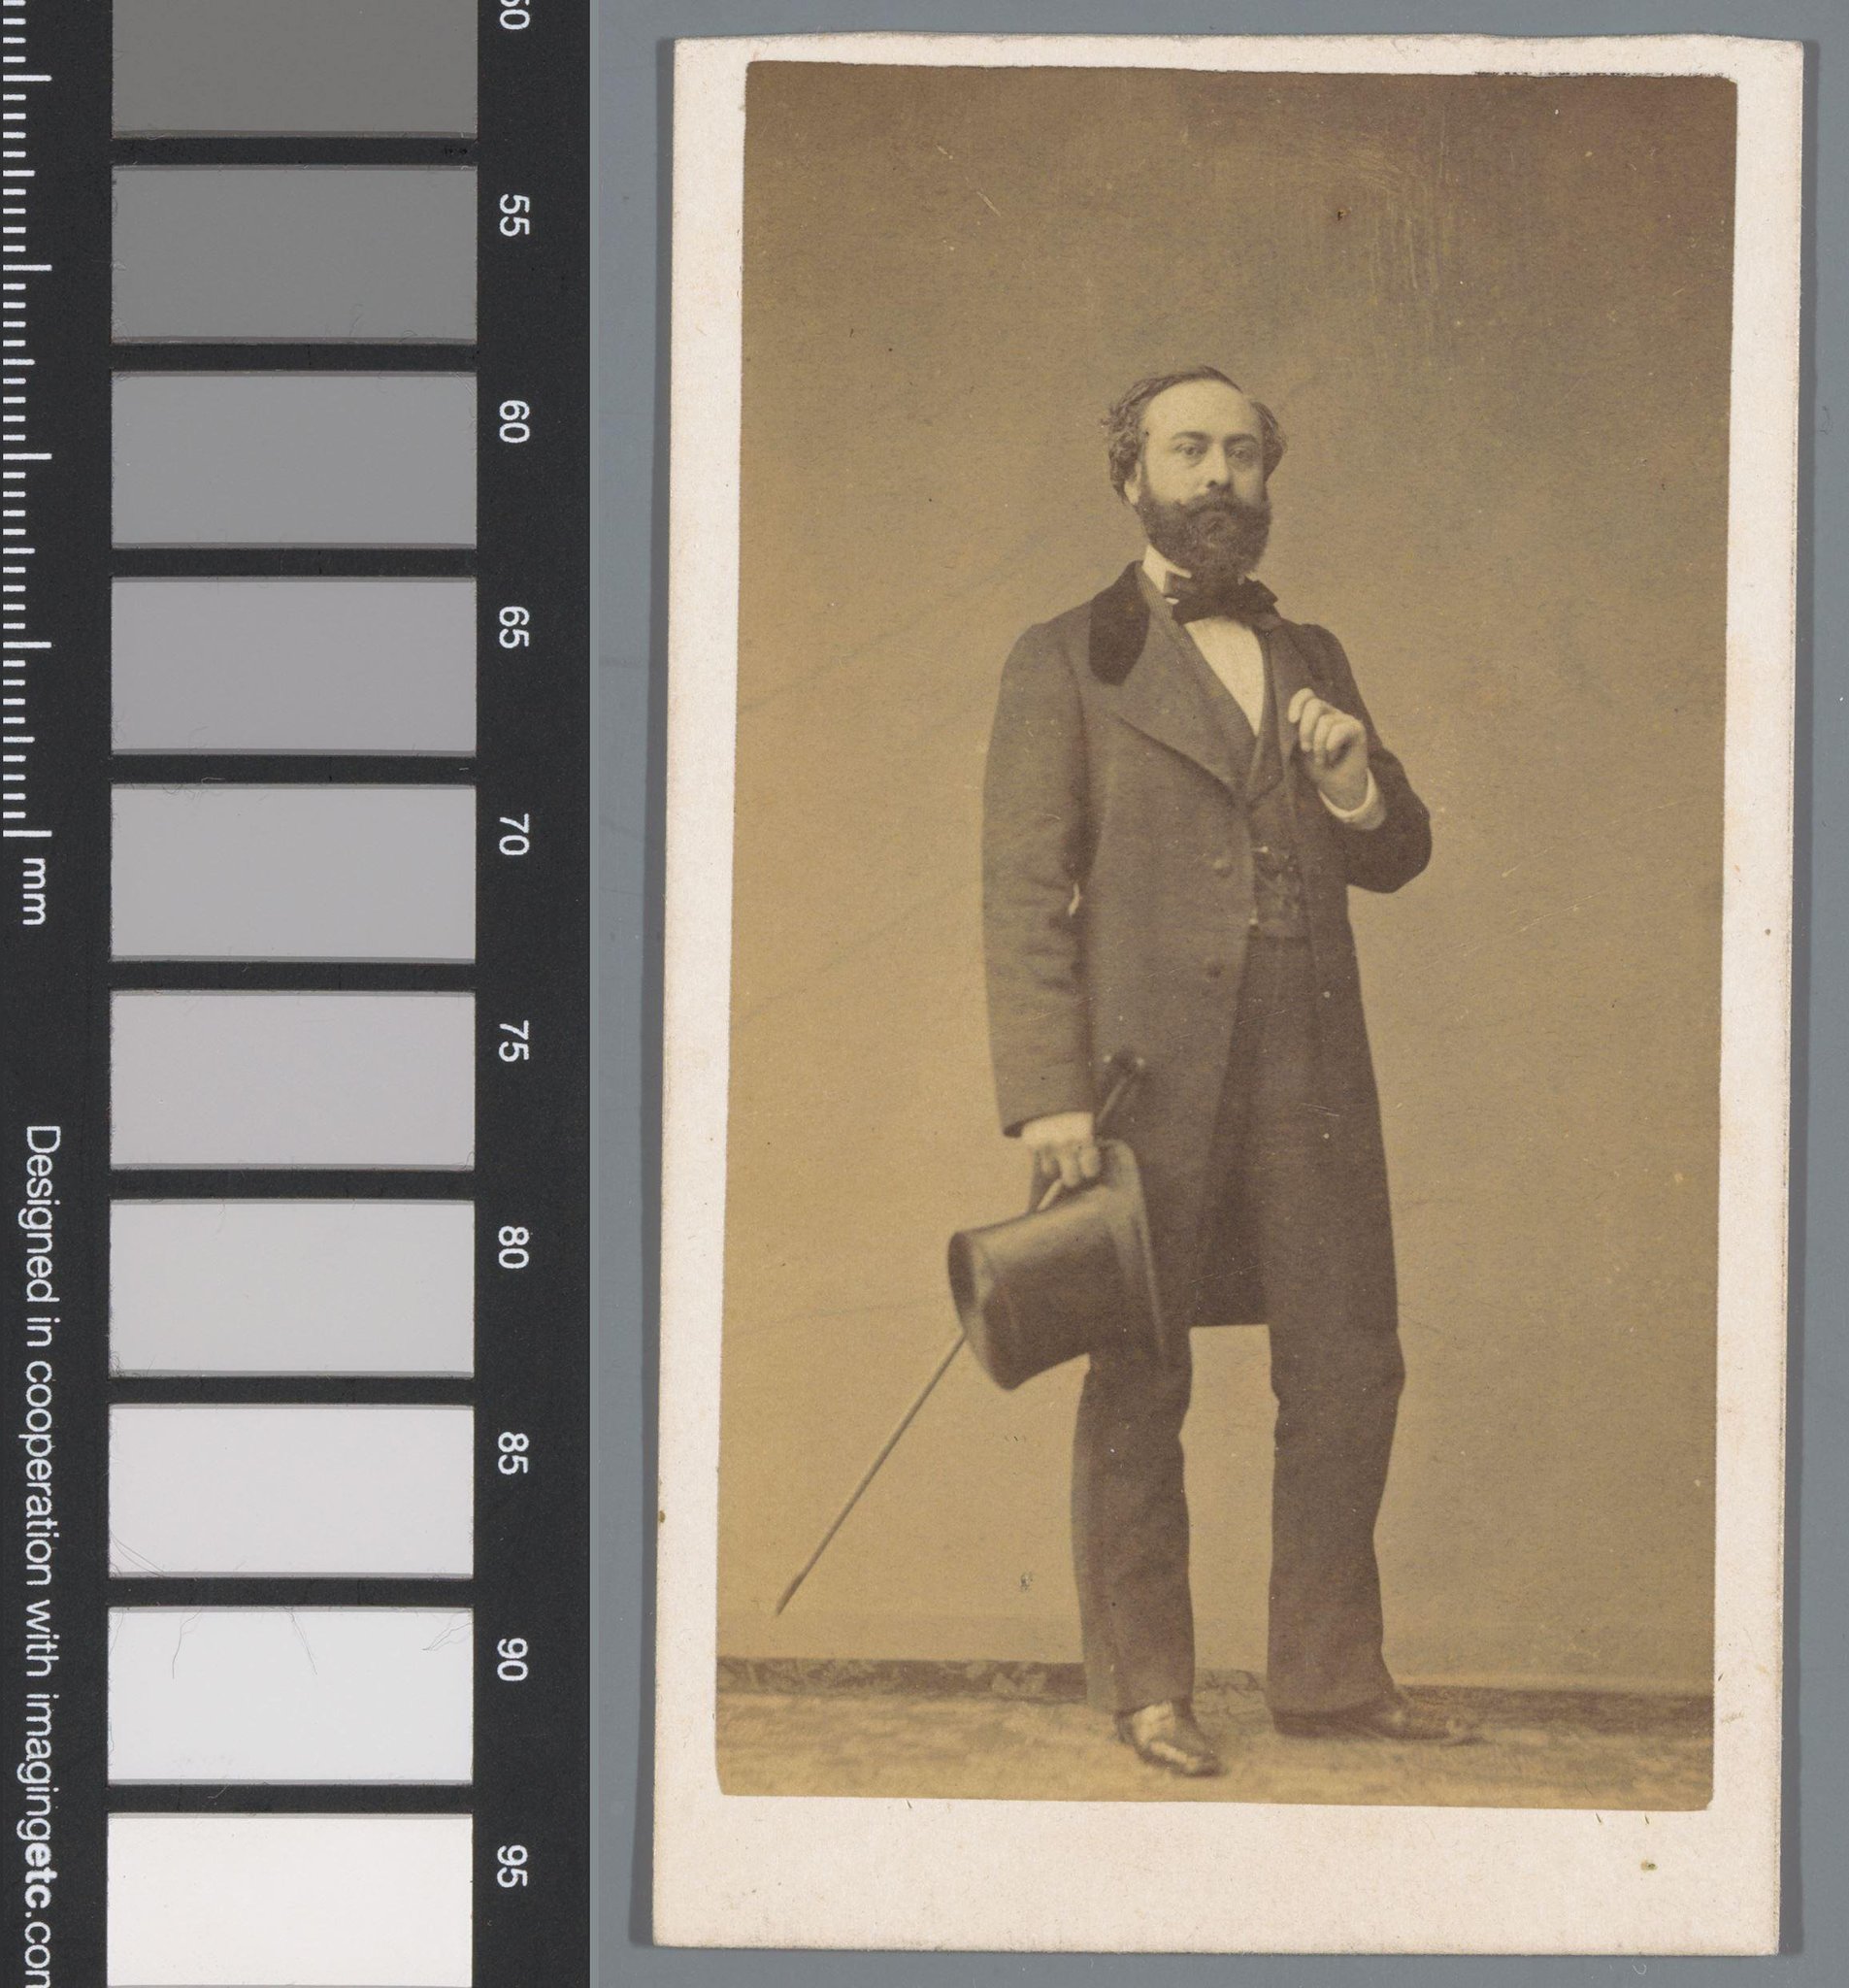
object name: carte de visite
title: Portret van Henry Baudin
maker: pierre petit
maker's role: fotograaf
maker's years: 1832-1909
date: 1860-1875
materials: cardboard, paper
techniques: albumen print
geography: paris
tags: walking-stick, staff, adult man, historical persons, head-gear: top hat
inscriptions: inscription: ‘Mr. Henry Baudin’, inscription: ‘PHOTOGRAPHIE DES DEUX MONDES/ EXPOSITION UNIVERSELLE/ PARIS BESANÇON/ PIERRE PETIT/ PHOTOGRAPHE/ 31. PLACE CADET./ PARIS/ PRUSSE BADE’